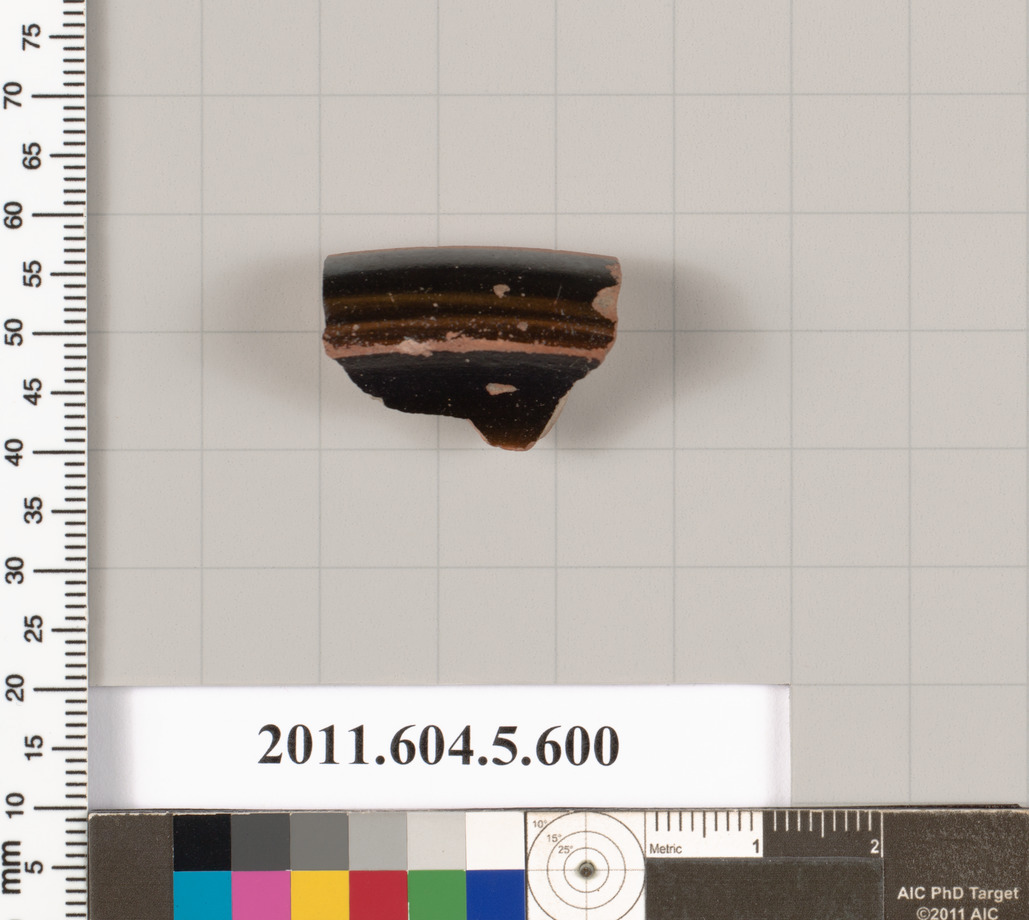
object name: kylix fragment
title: Terracotta fragment of a kylix (drinking cup)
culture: greek, attic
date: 600-401 BCE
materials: terracotta